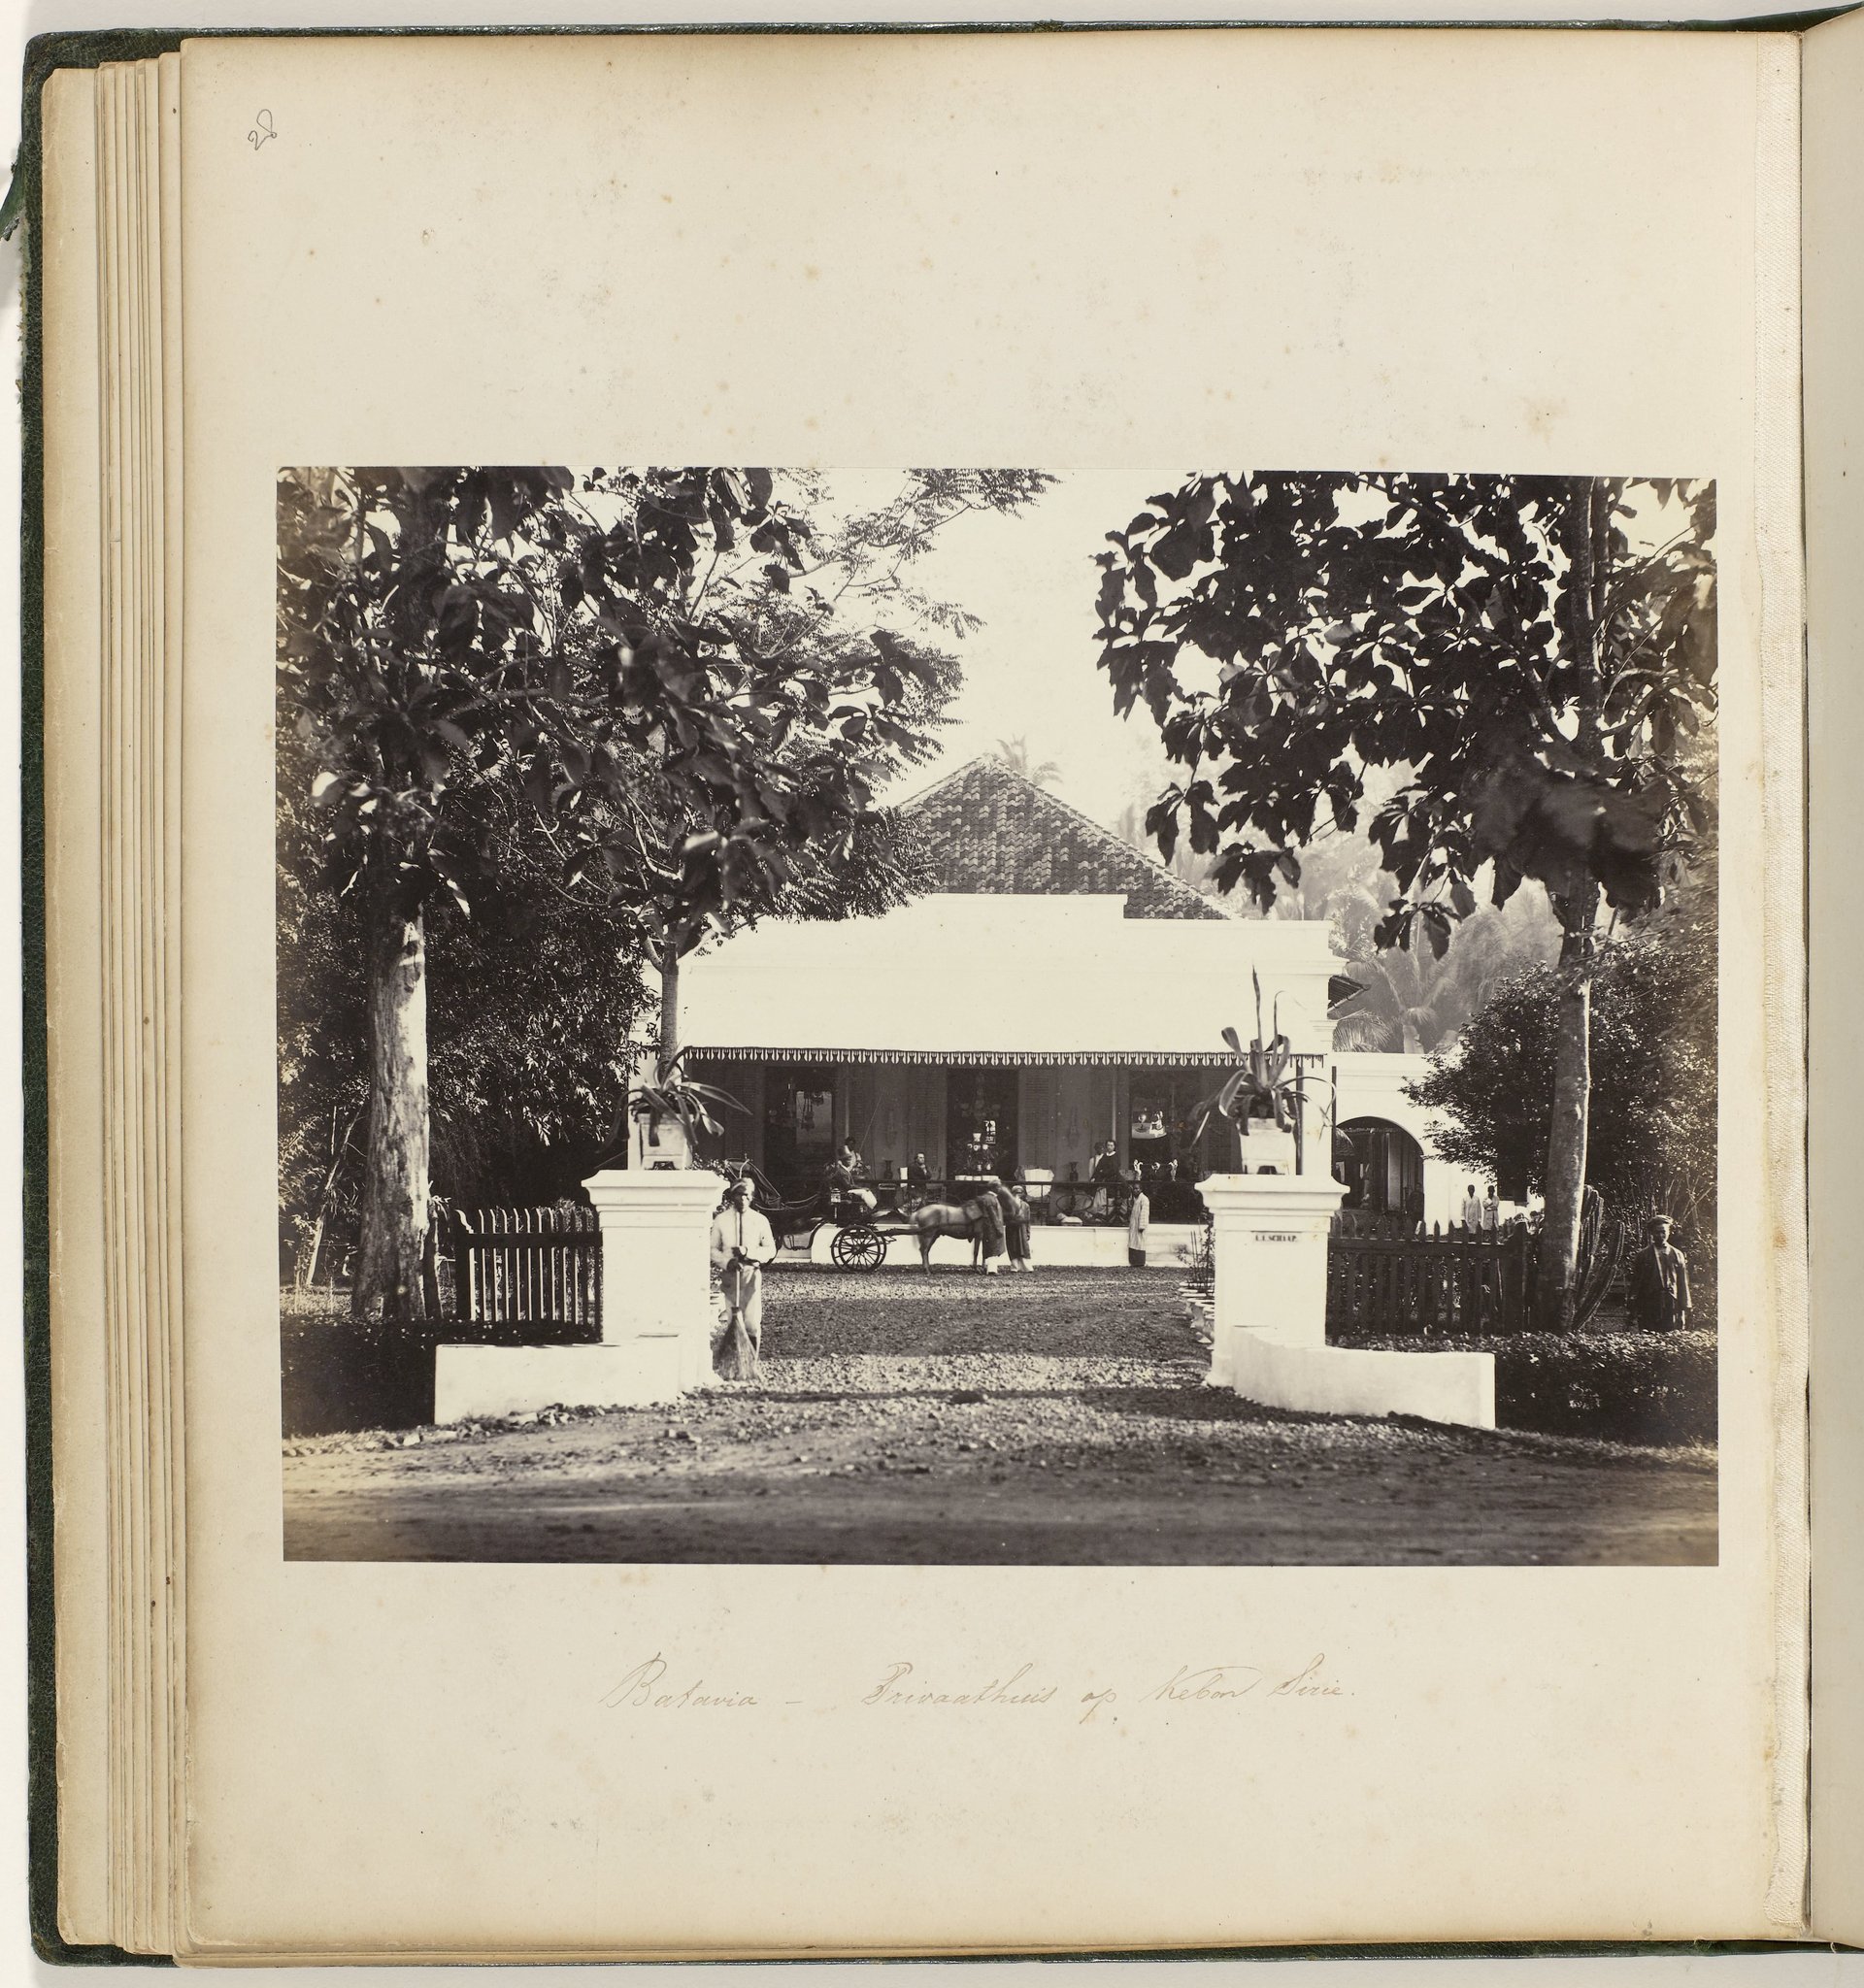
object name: photograph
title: Batavia - Privaathuis op Kebon Serie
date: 1863-1866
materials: photographic support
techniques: albumen print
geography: batavia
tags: detached house in city, batavia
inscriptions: inscription: ‘Batavia - Privaathuis op Kebon Serie’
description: Gezicht op een woonhuis aan de weg Kebon Sirih in Batavia. Op de poort de naam A.A. Schenk. De bewoners poseren op de veranda van het huis, vooor het huis een rijtuig. Onderdeel van het tweede groene fotoalbum met foto's van Java, uit het bezit van apotheker Specht-Grijp, die in 1865 vanuit Batavia naar Nederland terugkeerde.